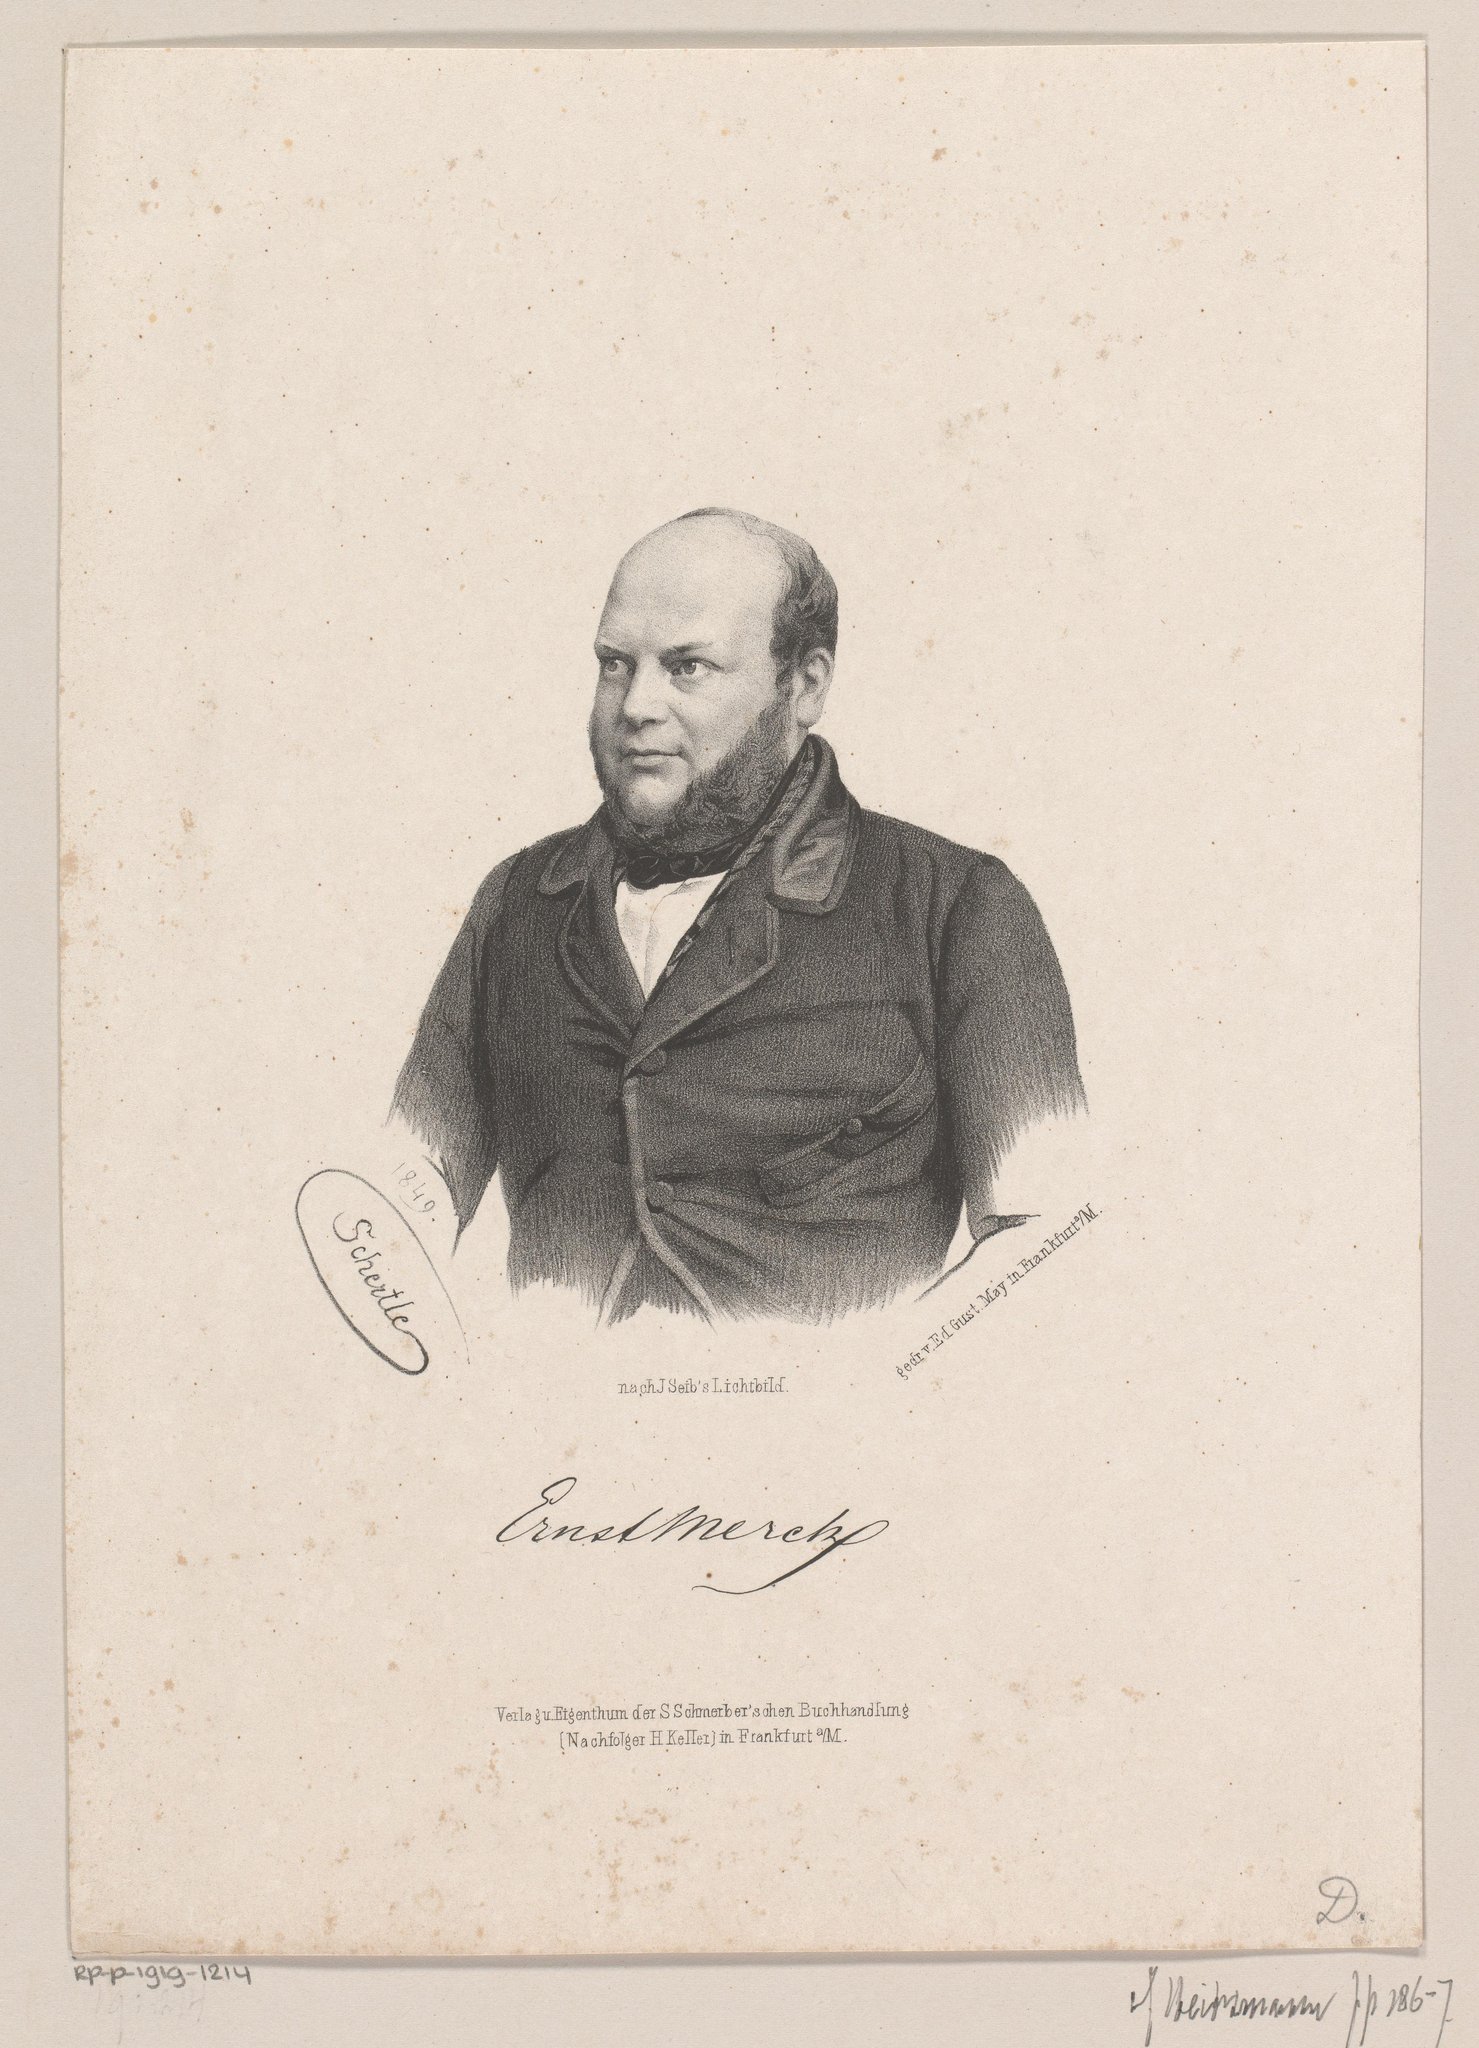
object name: print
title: Portretten van Duitse mannen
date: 1849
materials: paper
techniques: lithograph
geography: frankfurt am main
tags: politician, historical persons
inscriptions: collector's mark: Lugt 2228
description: Met facsimile signatuur van de geportretteerde.